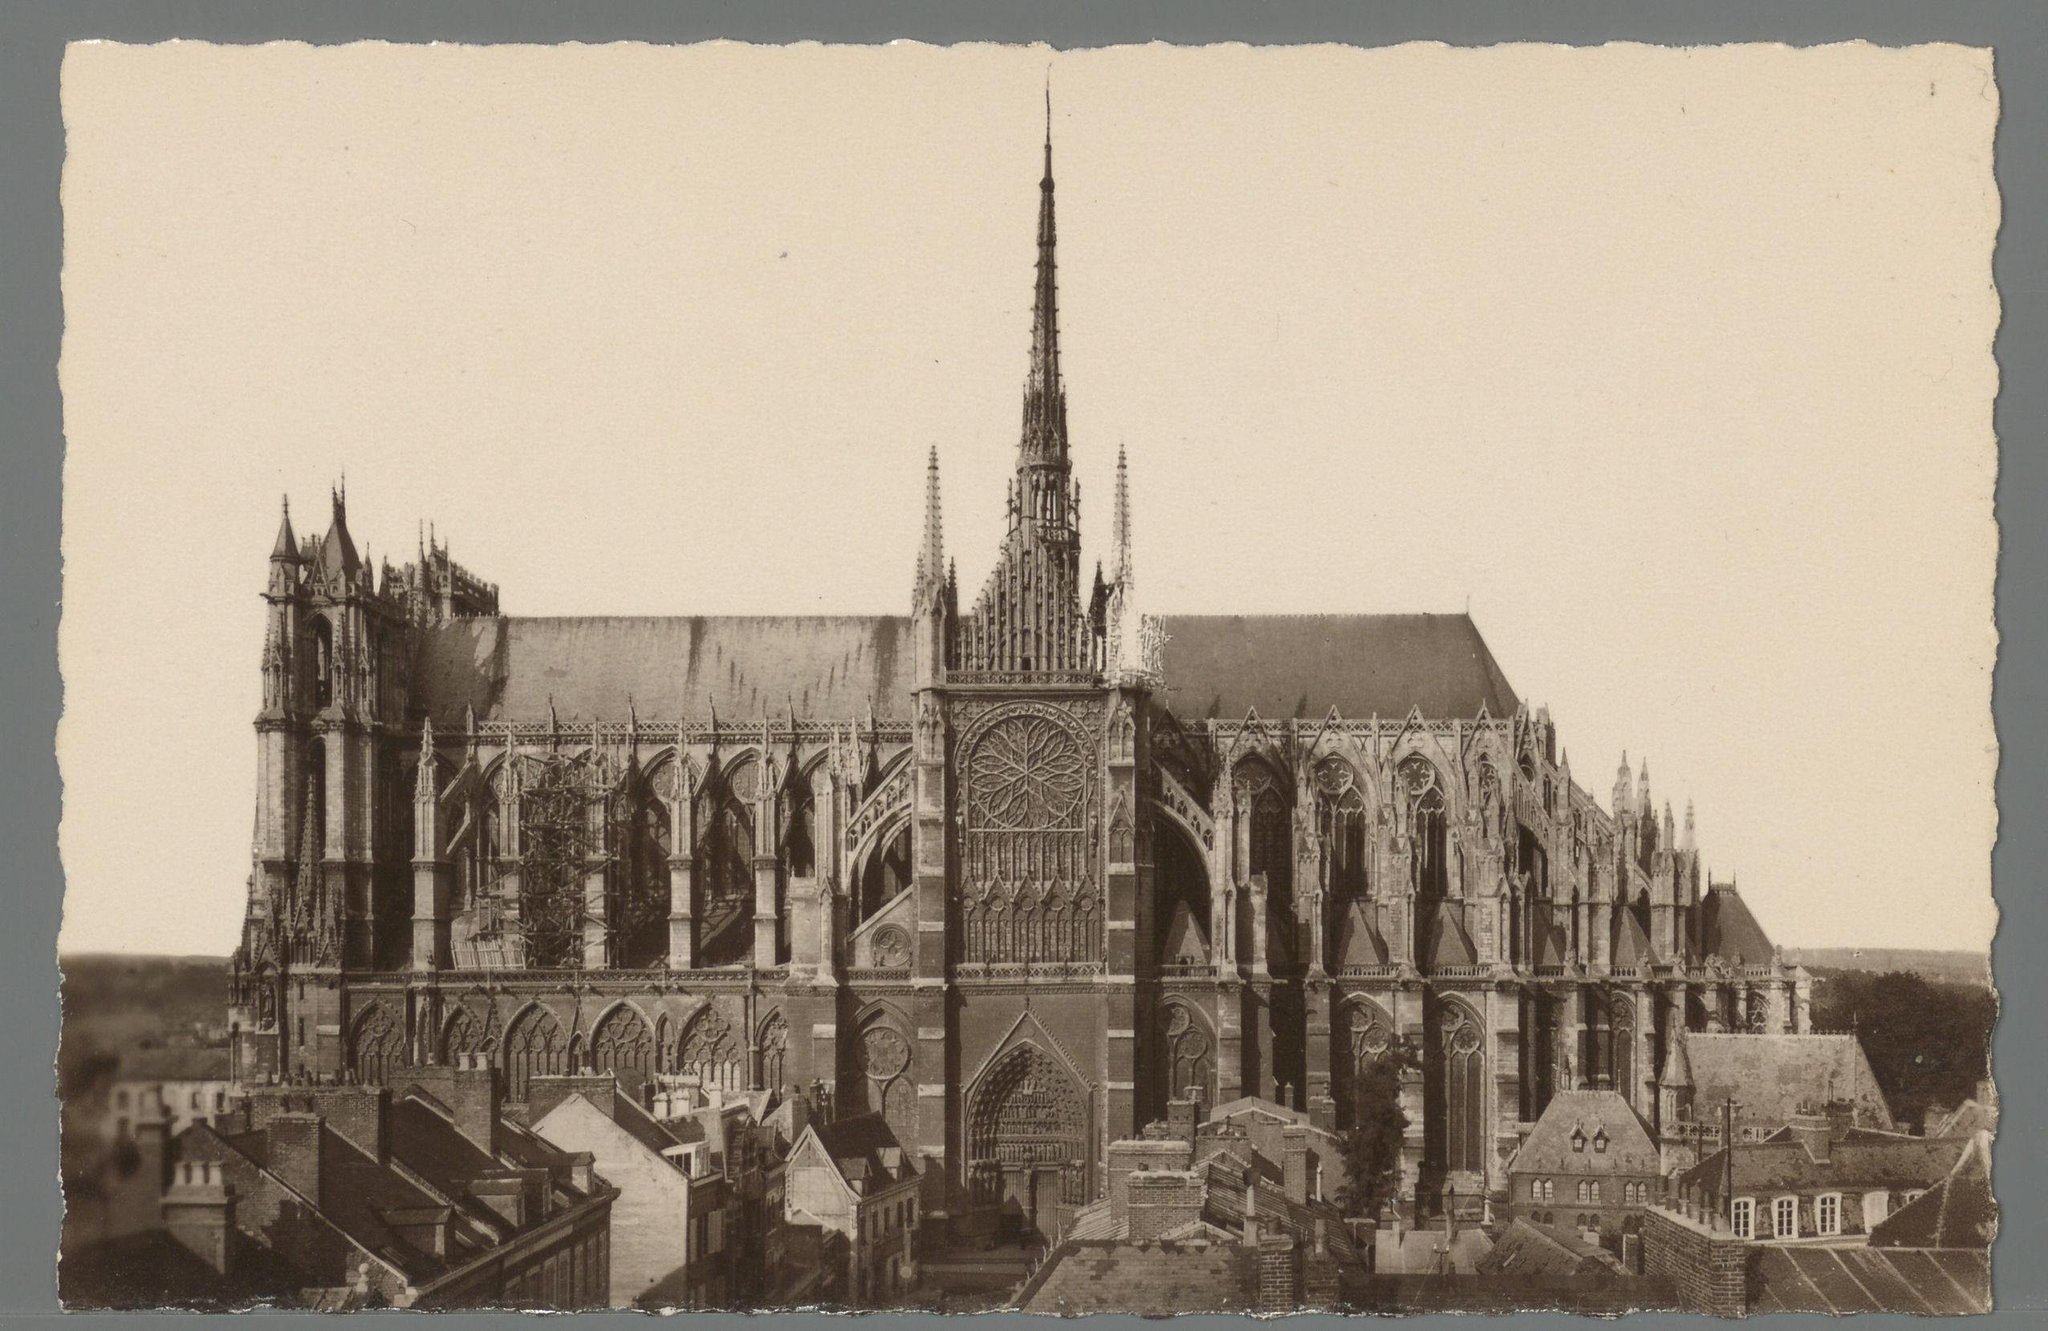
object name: photograph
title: Amiens (Somme). La Cathédrale. Elévation Sud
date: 1903-1950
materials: photographic support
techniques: photography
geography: amiens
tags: church (exterior), notre-dame d'amiens